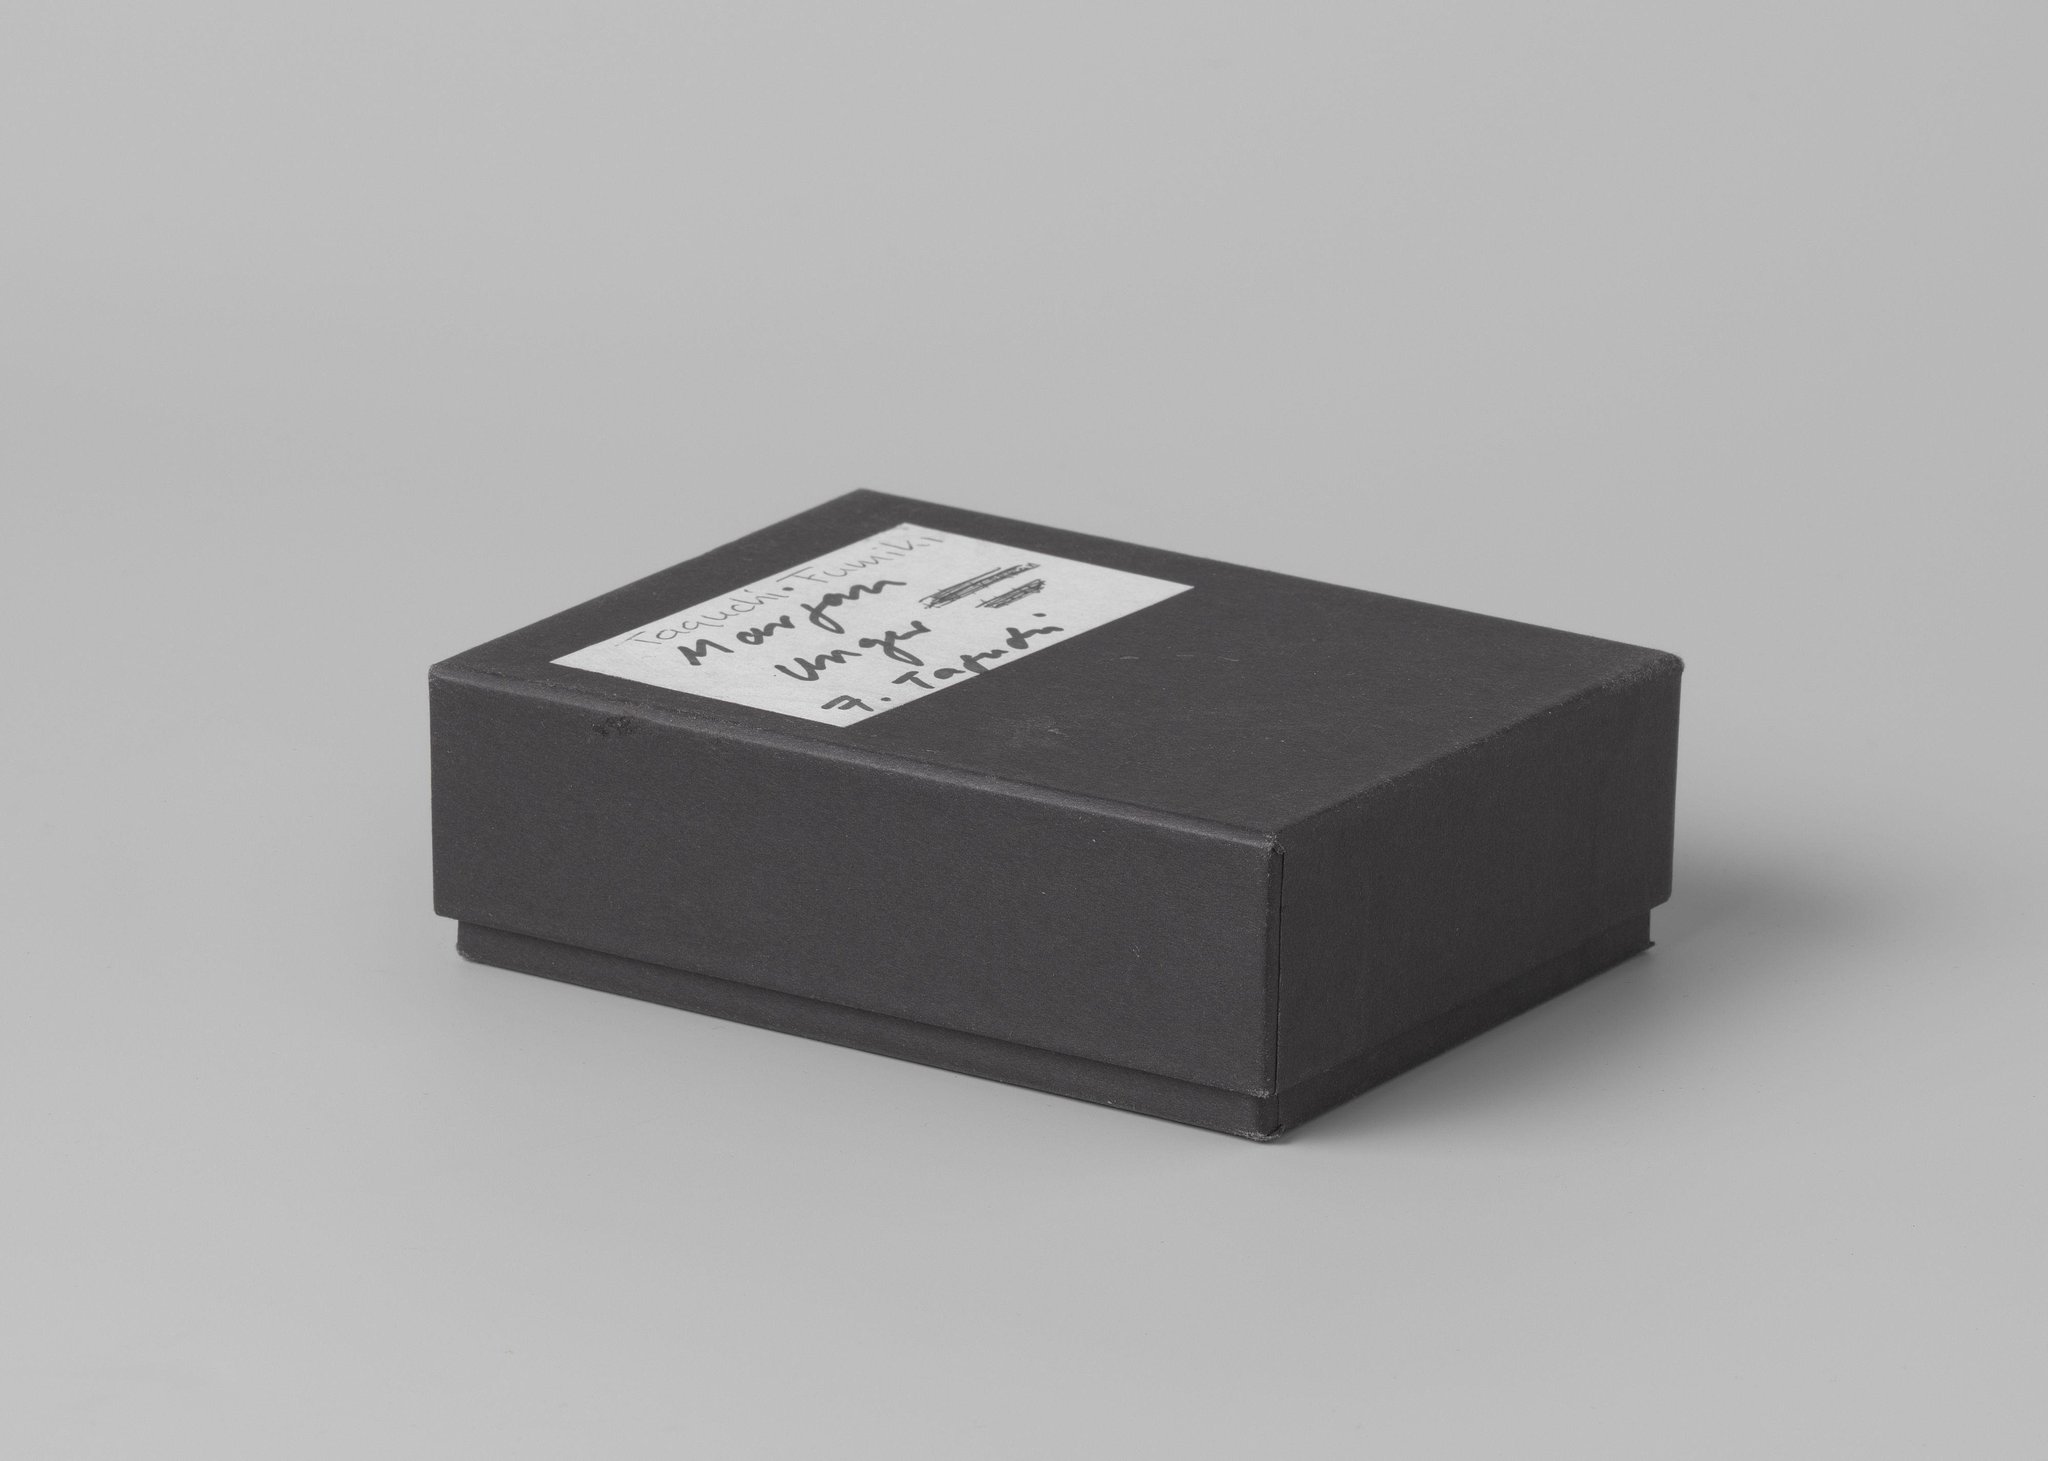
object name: box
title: Doos van zwart karton en los deksel en zwart schuimrubber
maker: fumiki taguchi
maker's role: designer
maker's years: 1977-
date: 2012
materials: cardboard, rubber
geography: japan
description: Doos ter verpakking van "Expression of white".